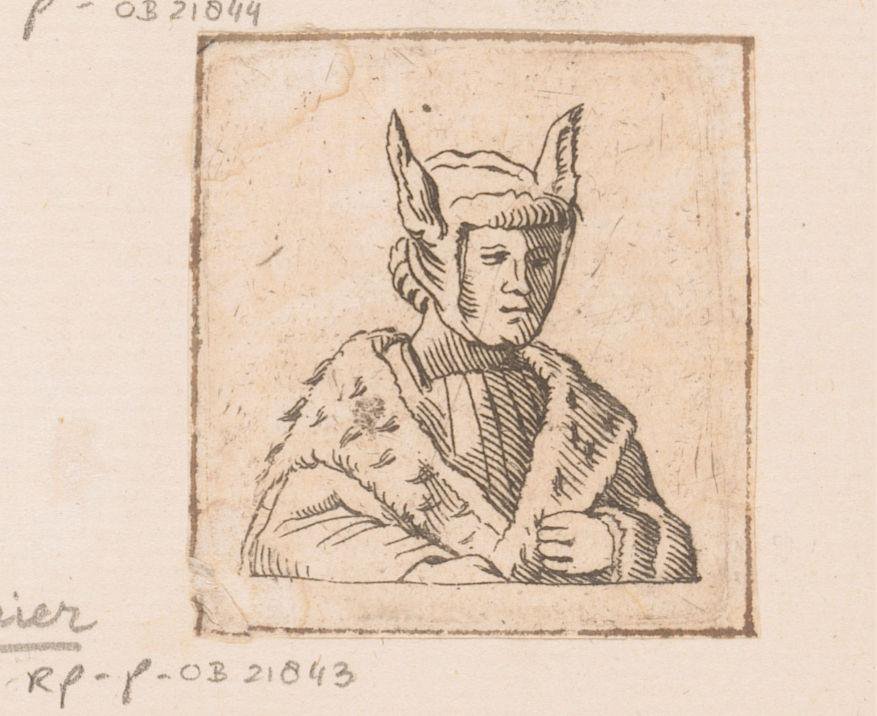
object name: book illustration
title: Illustraties uit de Lof der Zotheid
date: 1516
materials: paper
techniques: etching, letterpress printing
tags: rotterdam, desiderius erasmus, midas given ass's ears: apollo gives midas ass's ears as punishment for preferring pan in the musical contest between apollo and pan (ovid, metamorphoses xi 174)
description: Prent afkomstig uit: Erasmus, Desiderius. Morias enkomion (...). Bazel: Johann Rudolf Genath, 1676. De prenten hierin zijn naar tekeningen die Hans en Ambrosius Holbein maakten voor de theoloog Oswald Myconius in diens uitgave van de Moriae encomium (Lof der Zotheid) van 1516.